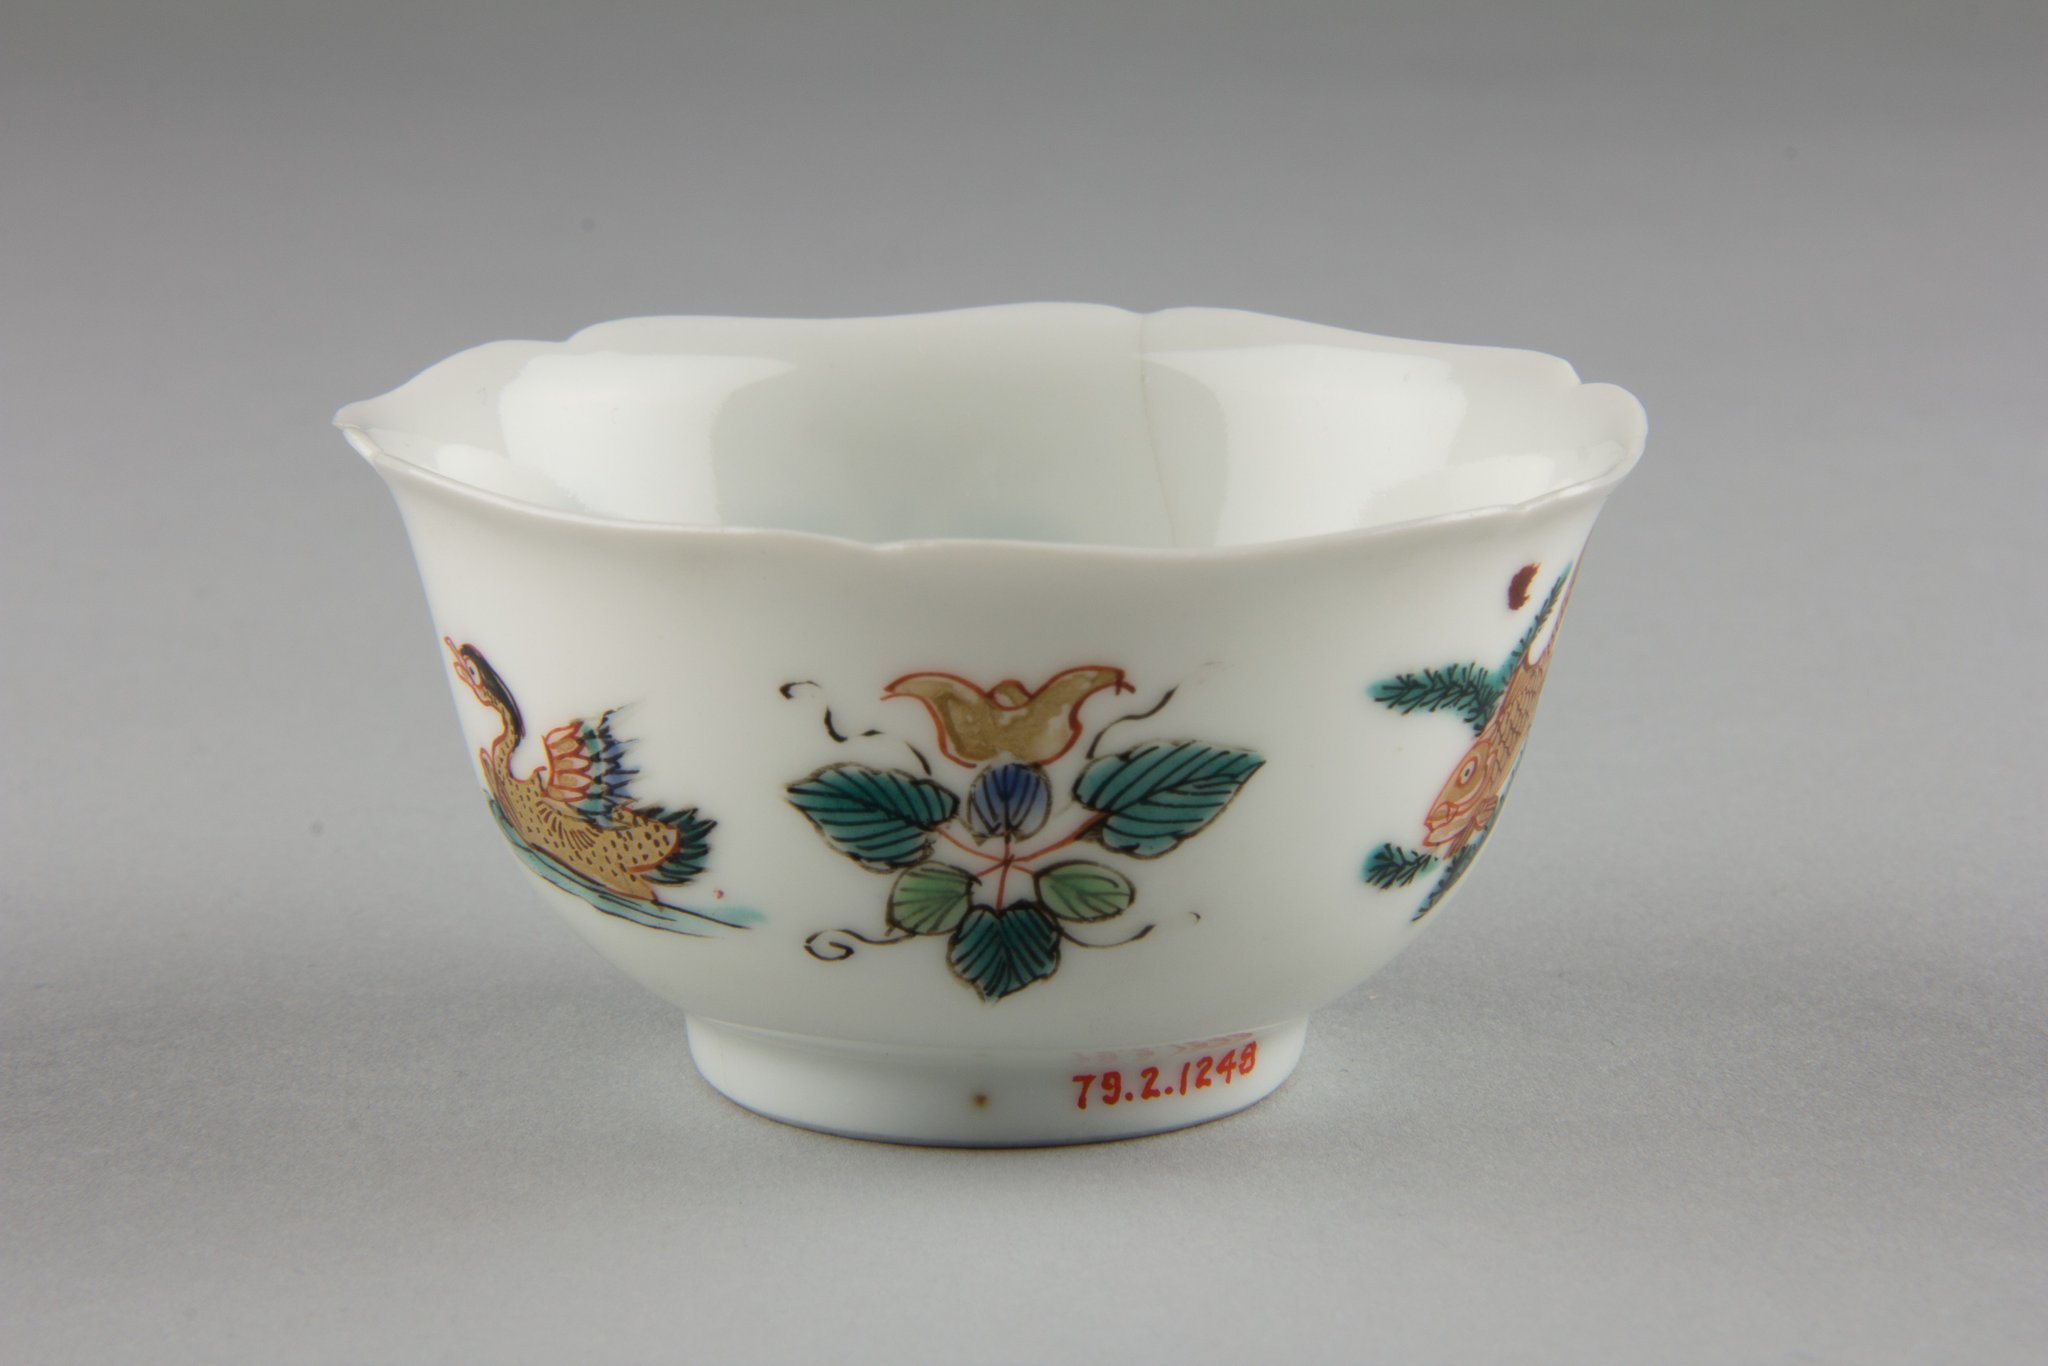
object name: cup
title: Cup with duck, fish, and flowers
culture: chinese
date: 1767-1833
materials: enamel, porcelain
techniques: overglaze, painting, polychrome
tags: ducks,fish